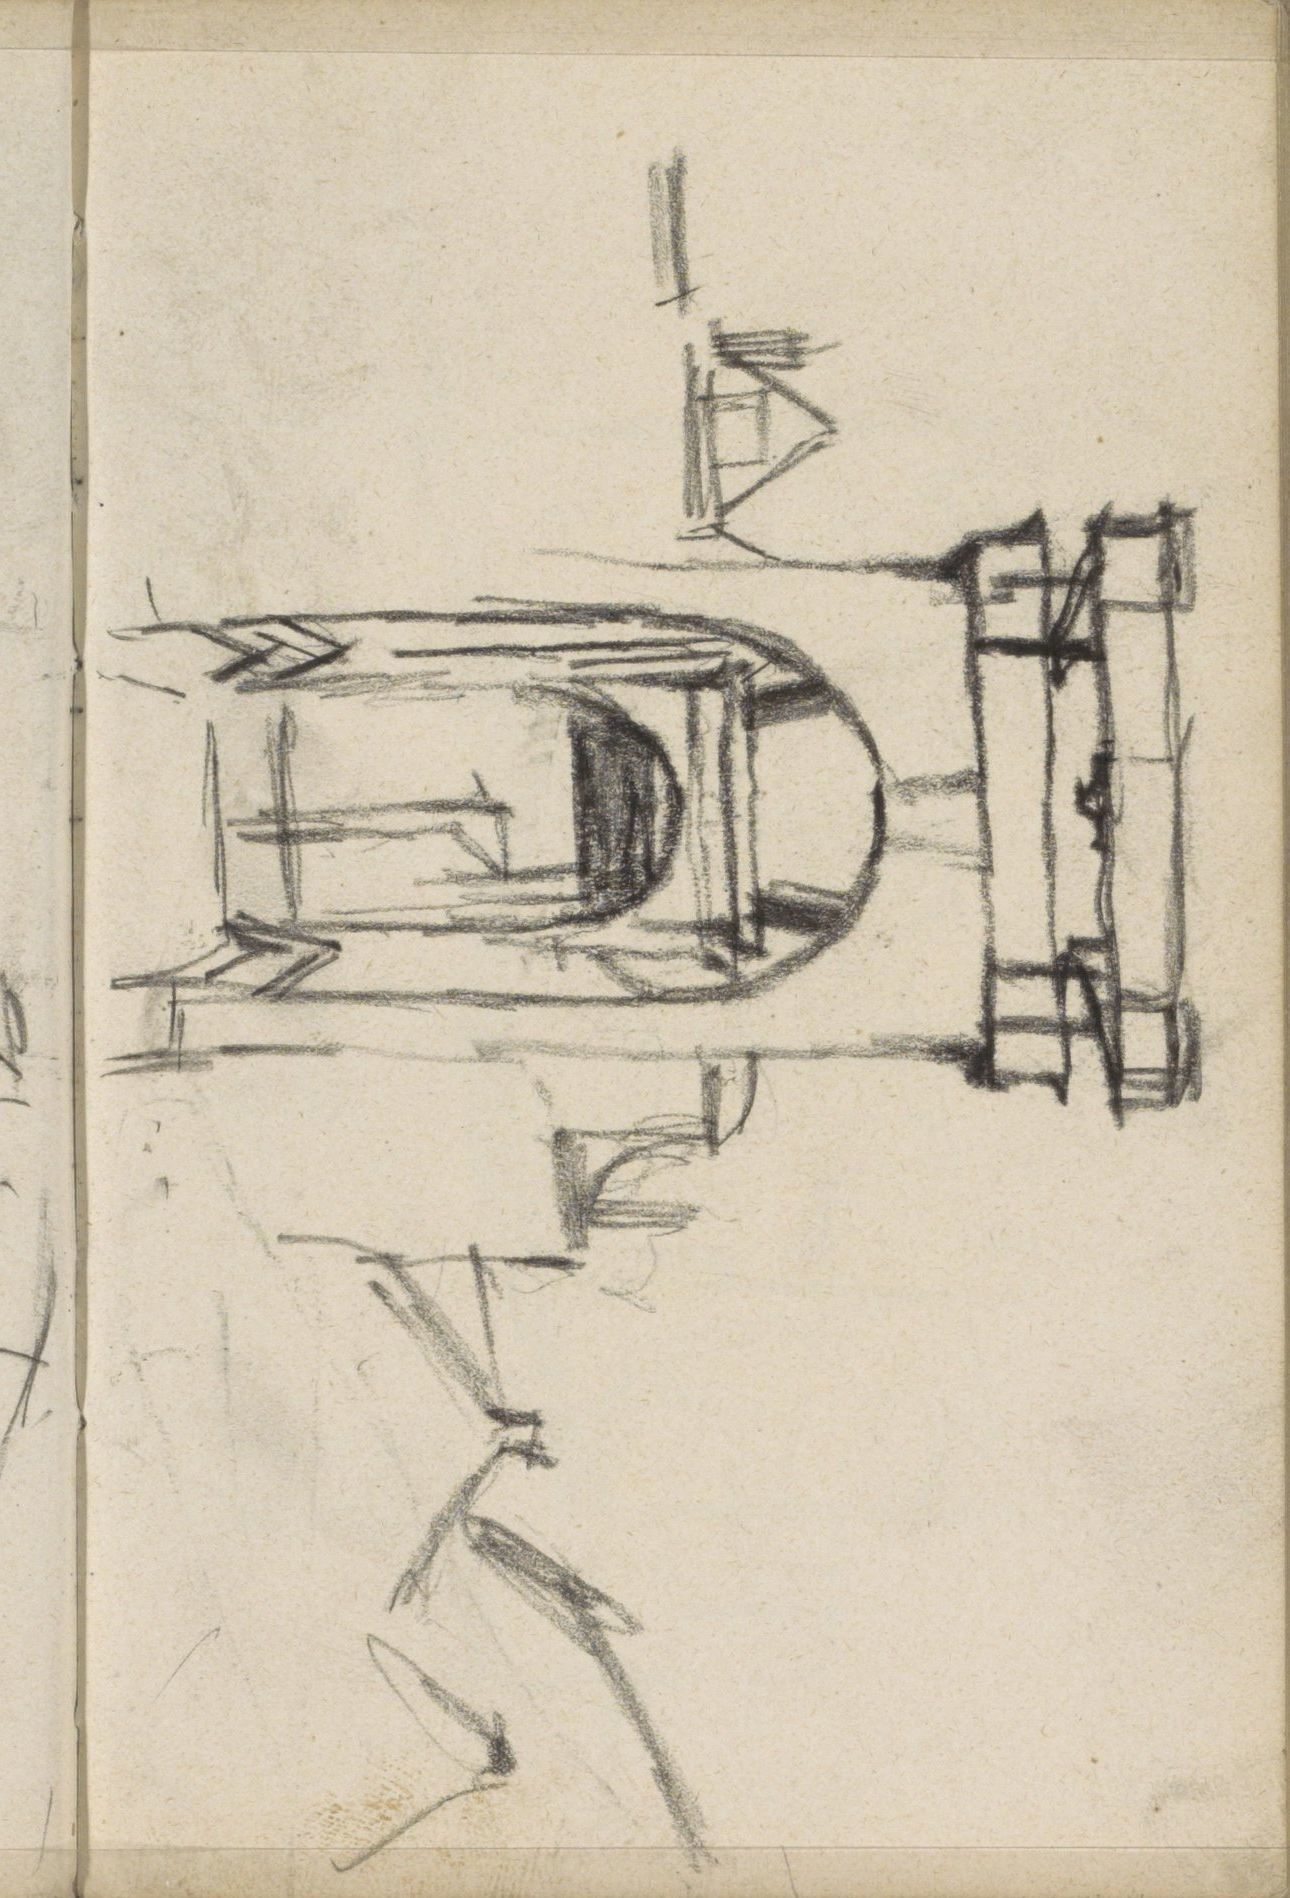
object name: sketchbook leaf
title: Gezicht op de Sloterdijkbrug te Amsterdam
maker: george hendrik breitner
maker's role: draughtsman, painter, print maker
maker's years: 1857-1923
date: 1907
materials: chalk, paper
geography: amsterdam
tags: bridge in city across river, canal, etc.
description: Gezicht op de Sloterdijkbrug te Amsterdam. Op de achtergrond Prinseneiland. Pagina 54 uit een schetsboek met 46 bladen vervaardigd in Amsterdam, Rotterdam en Haarlem.